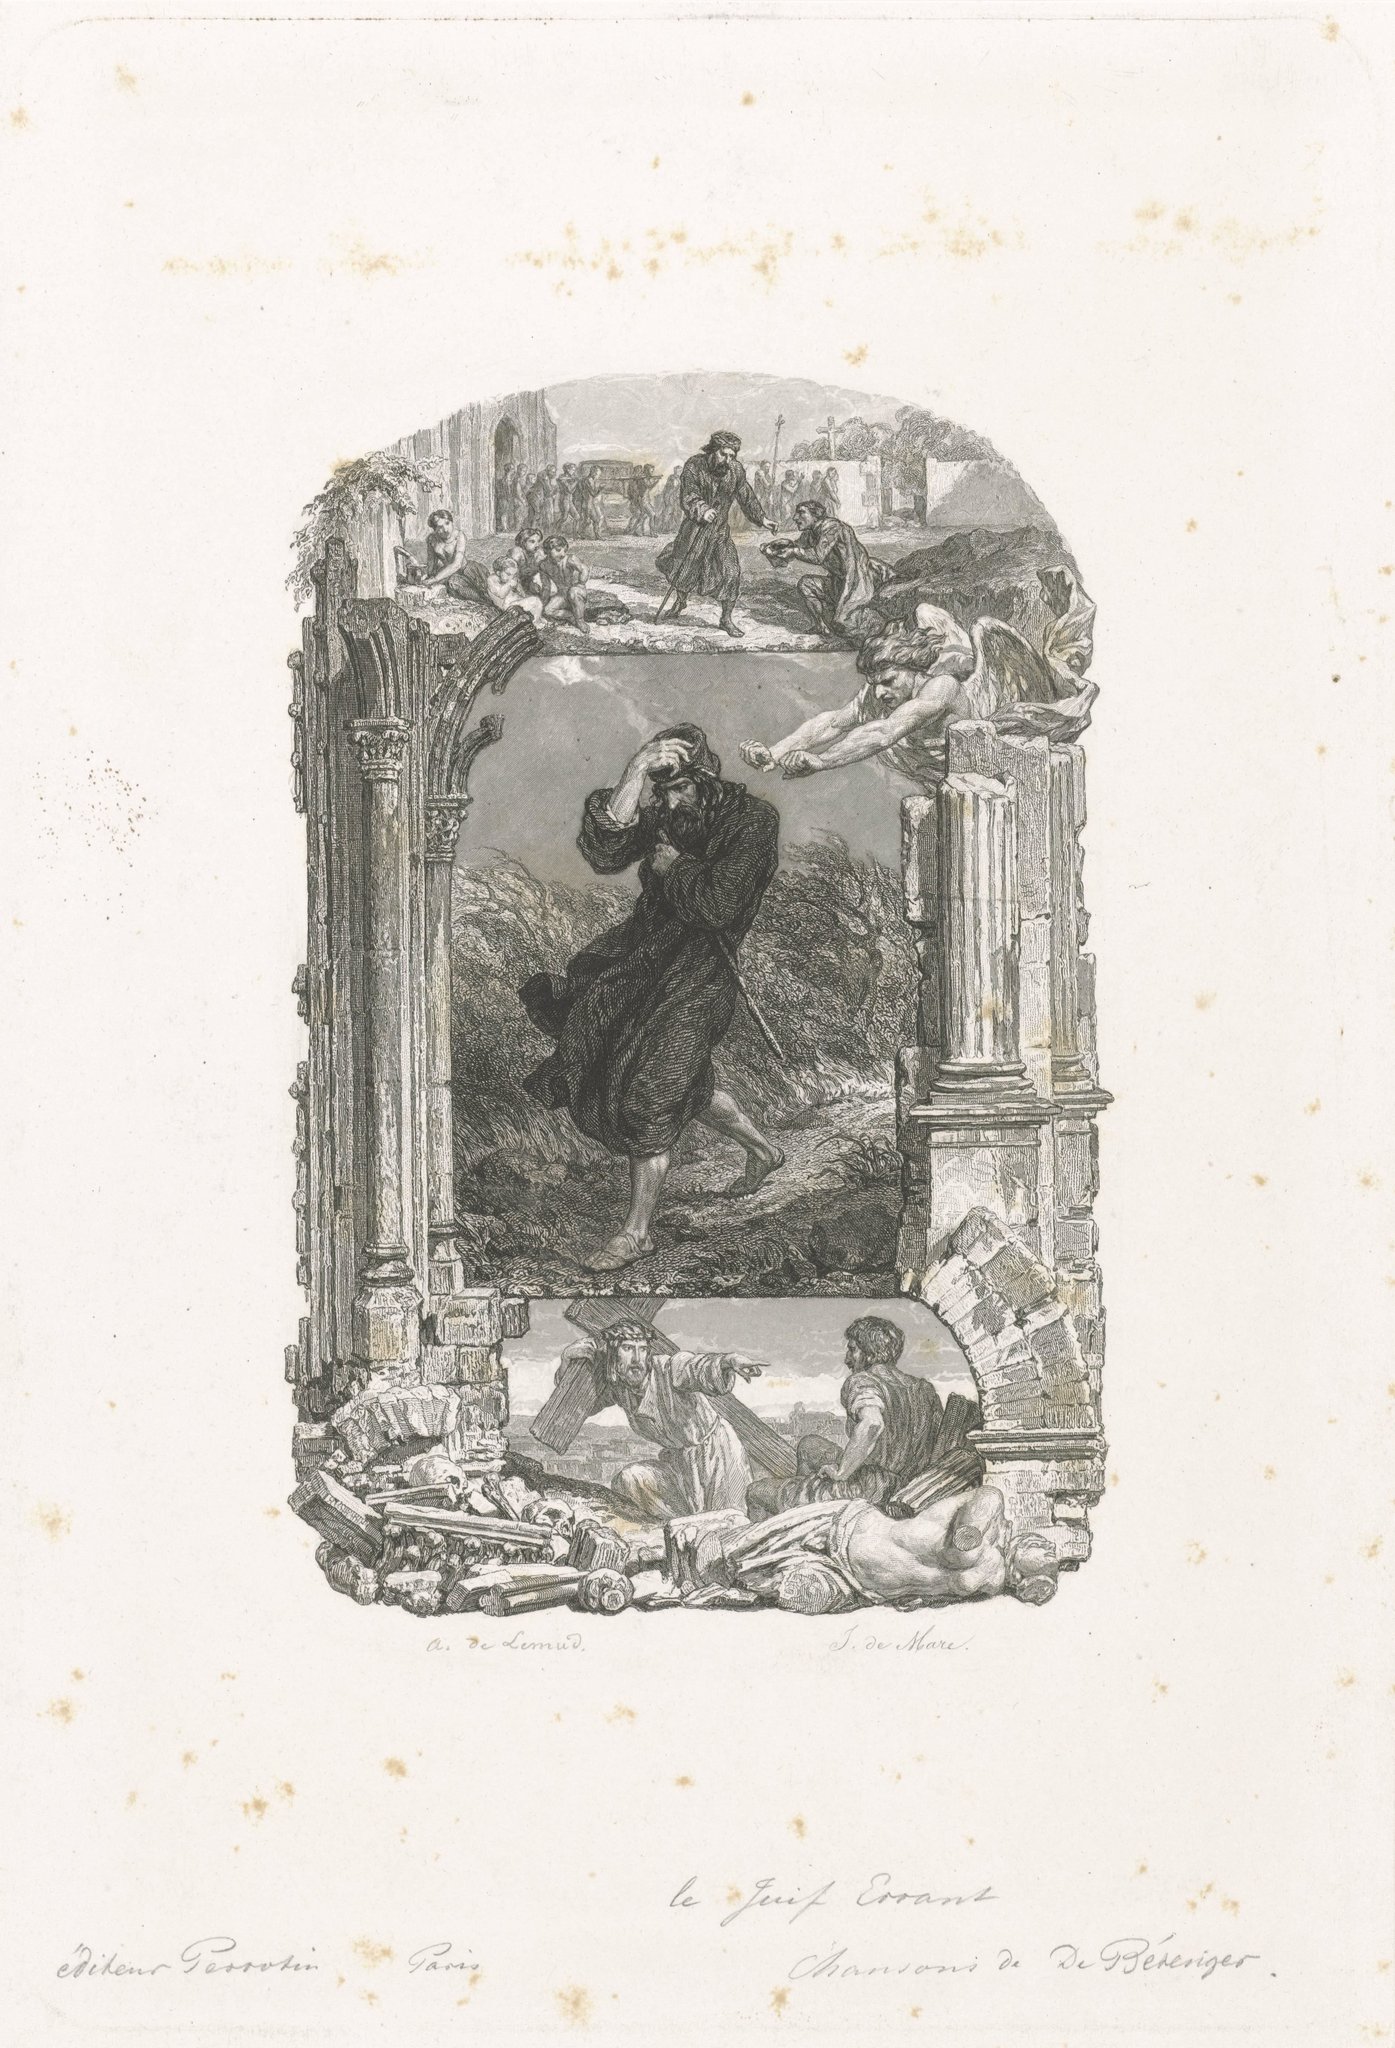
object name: print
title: Ahasverus, de Wandelende Jood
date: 1816-1889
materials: paper, pencil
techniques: engraving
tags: paris, pierre-jean de béranger, ahasverus, the wandering jew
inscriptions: inscription: ‘éditeur Perrotin Paris Chansons de De Béranger’, collector's mark: Lugt 2228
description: In de legende van Ahasverus, de Wandelende Jood, wordt de jood beladen met de vloek eeuwig te moeten zwerven. De kern van de legende komt er op neer dat een jood, doorgaans Ahasverus geheten, weigerde Christus op zijn kruisweg te drinken te geven en daarom werd beladen met de vloek. Bovenaan een scène waarin hij een bedelaar een aalmoes geeft met op de achtergrond een begrafenisstoet en onderaan Christus tijdens zijn kruisweg die naar hem wijst. In het midden loopt hij over een landweg, voortgeduwd door een (wraak)engel. Scène uit een chanson van Pierre-Jean de Béranger.